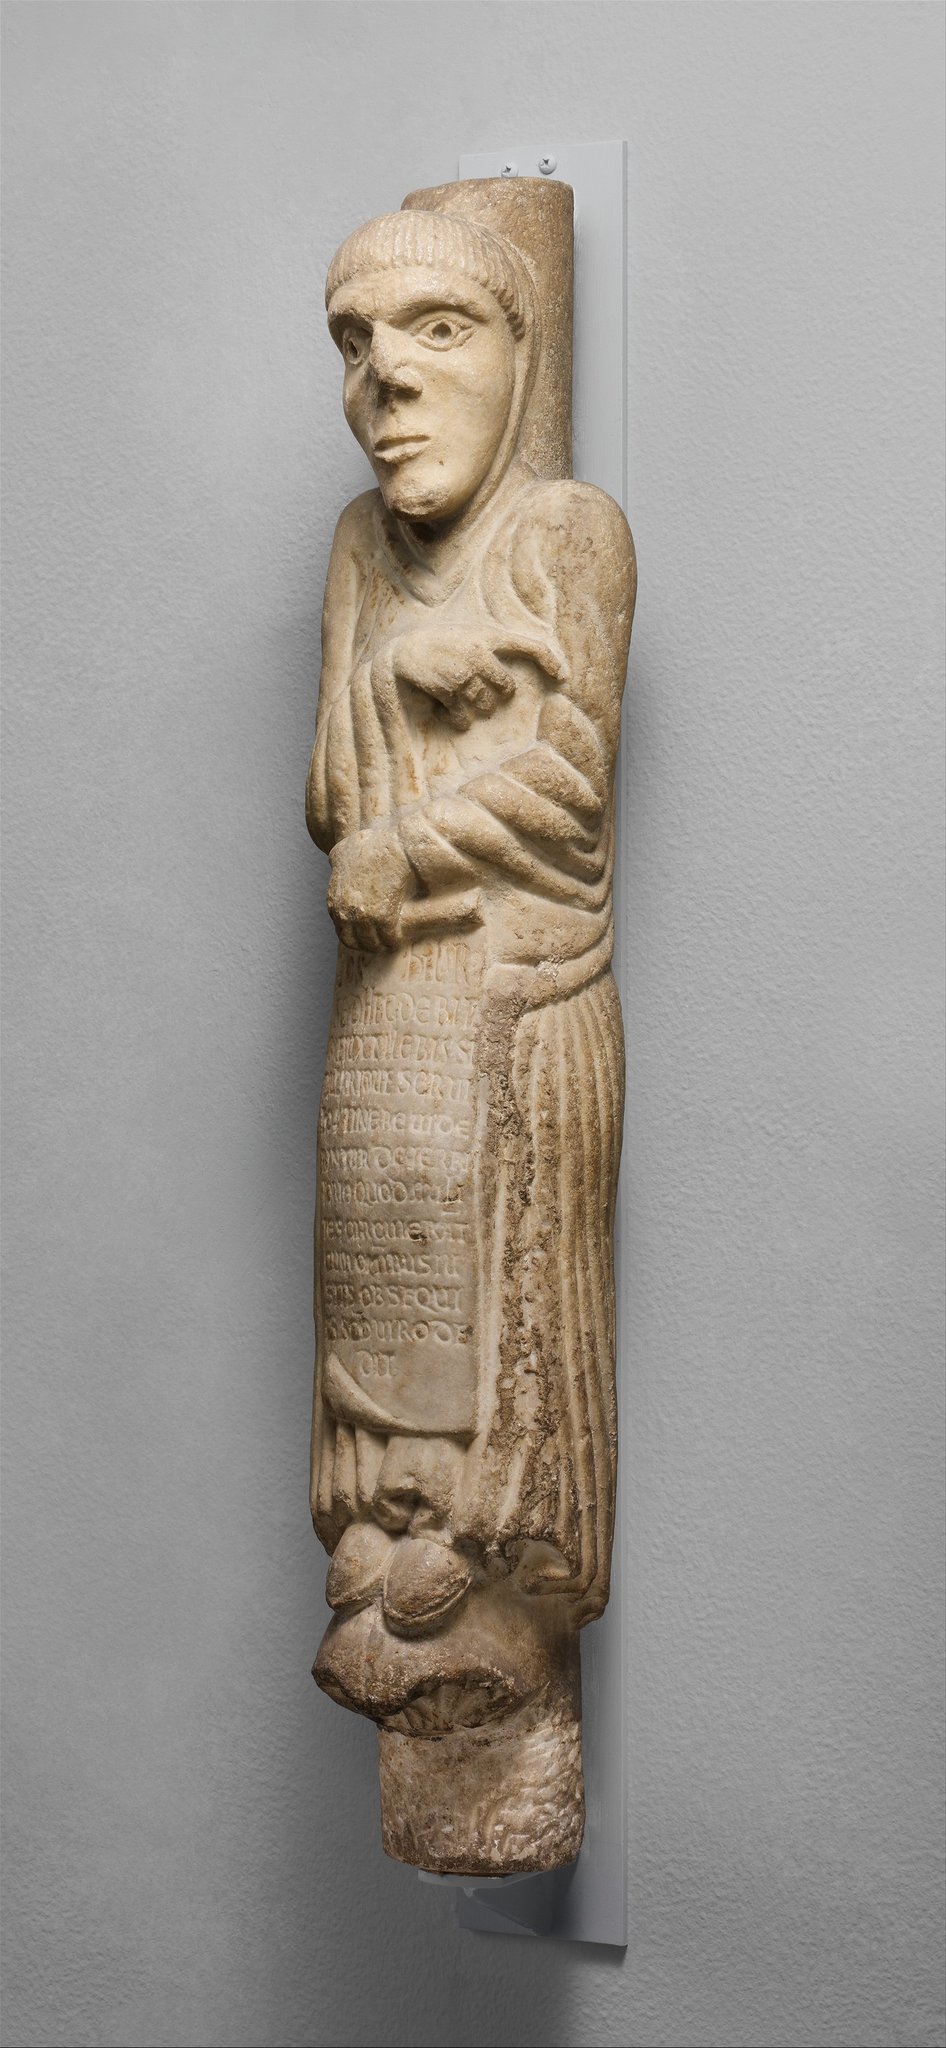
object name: statue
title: Column Statue of Saint Hilary of Galeata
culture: north italian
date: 1170-1200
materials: marble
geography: northern italy